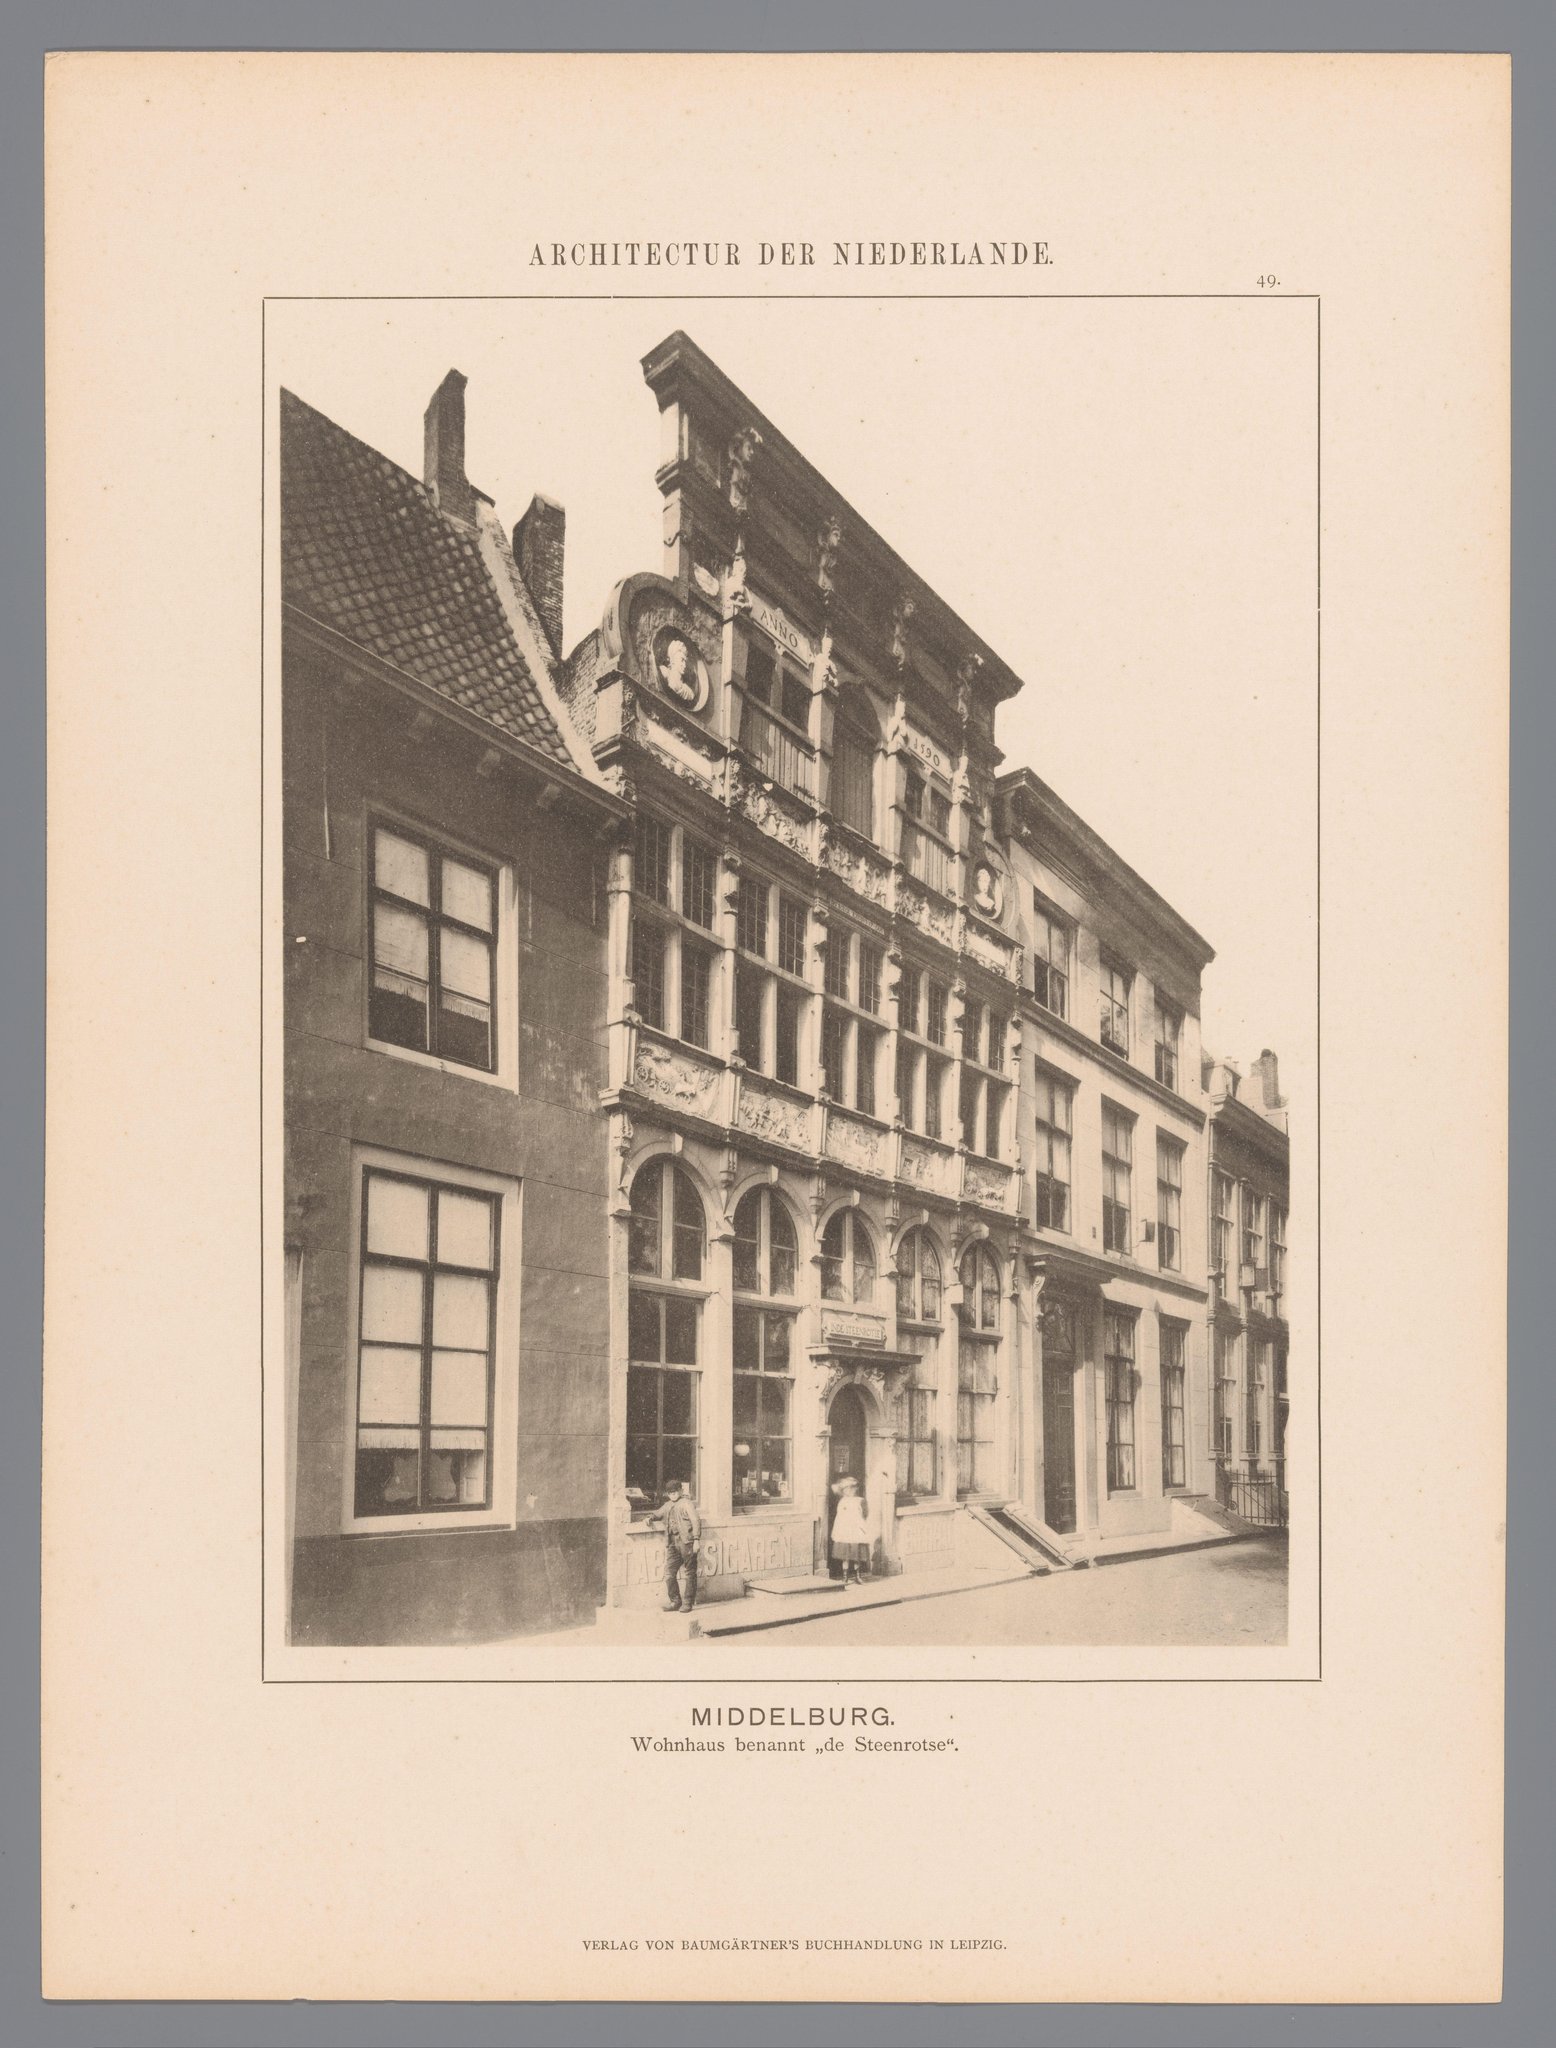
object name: photomechanical print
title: Architectur der Niederlande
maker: Anonymous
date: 1894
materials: paper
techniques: photograph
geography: leipzig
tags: urban housing, middelburg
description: Afdruk uit: Krook, L. Architectur der Niederlande. Leipzig: Baumgärtner's Buchhandlung, 1894.